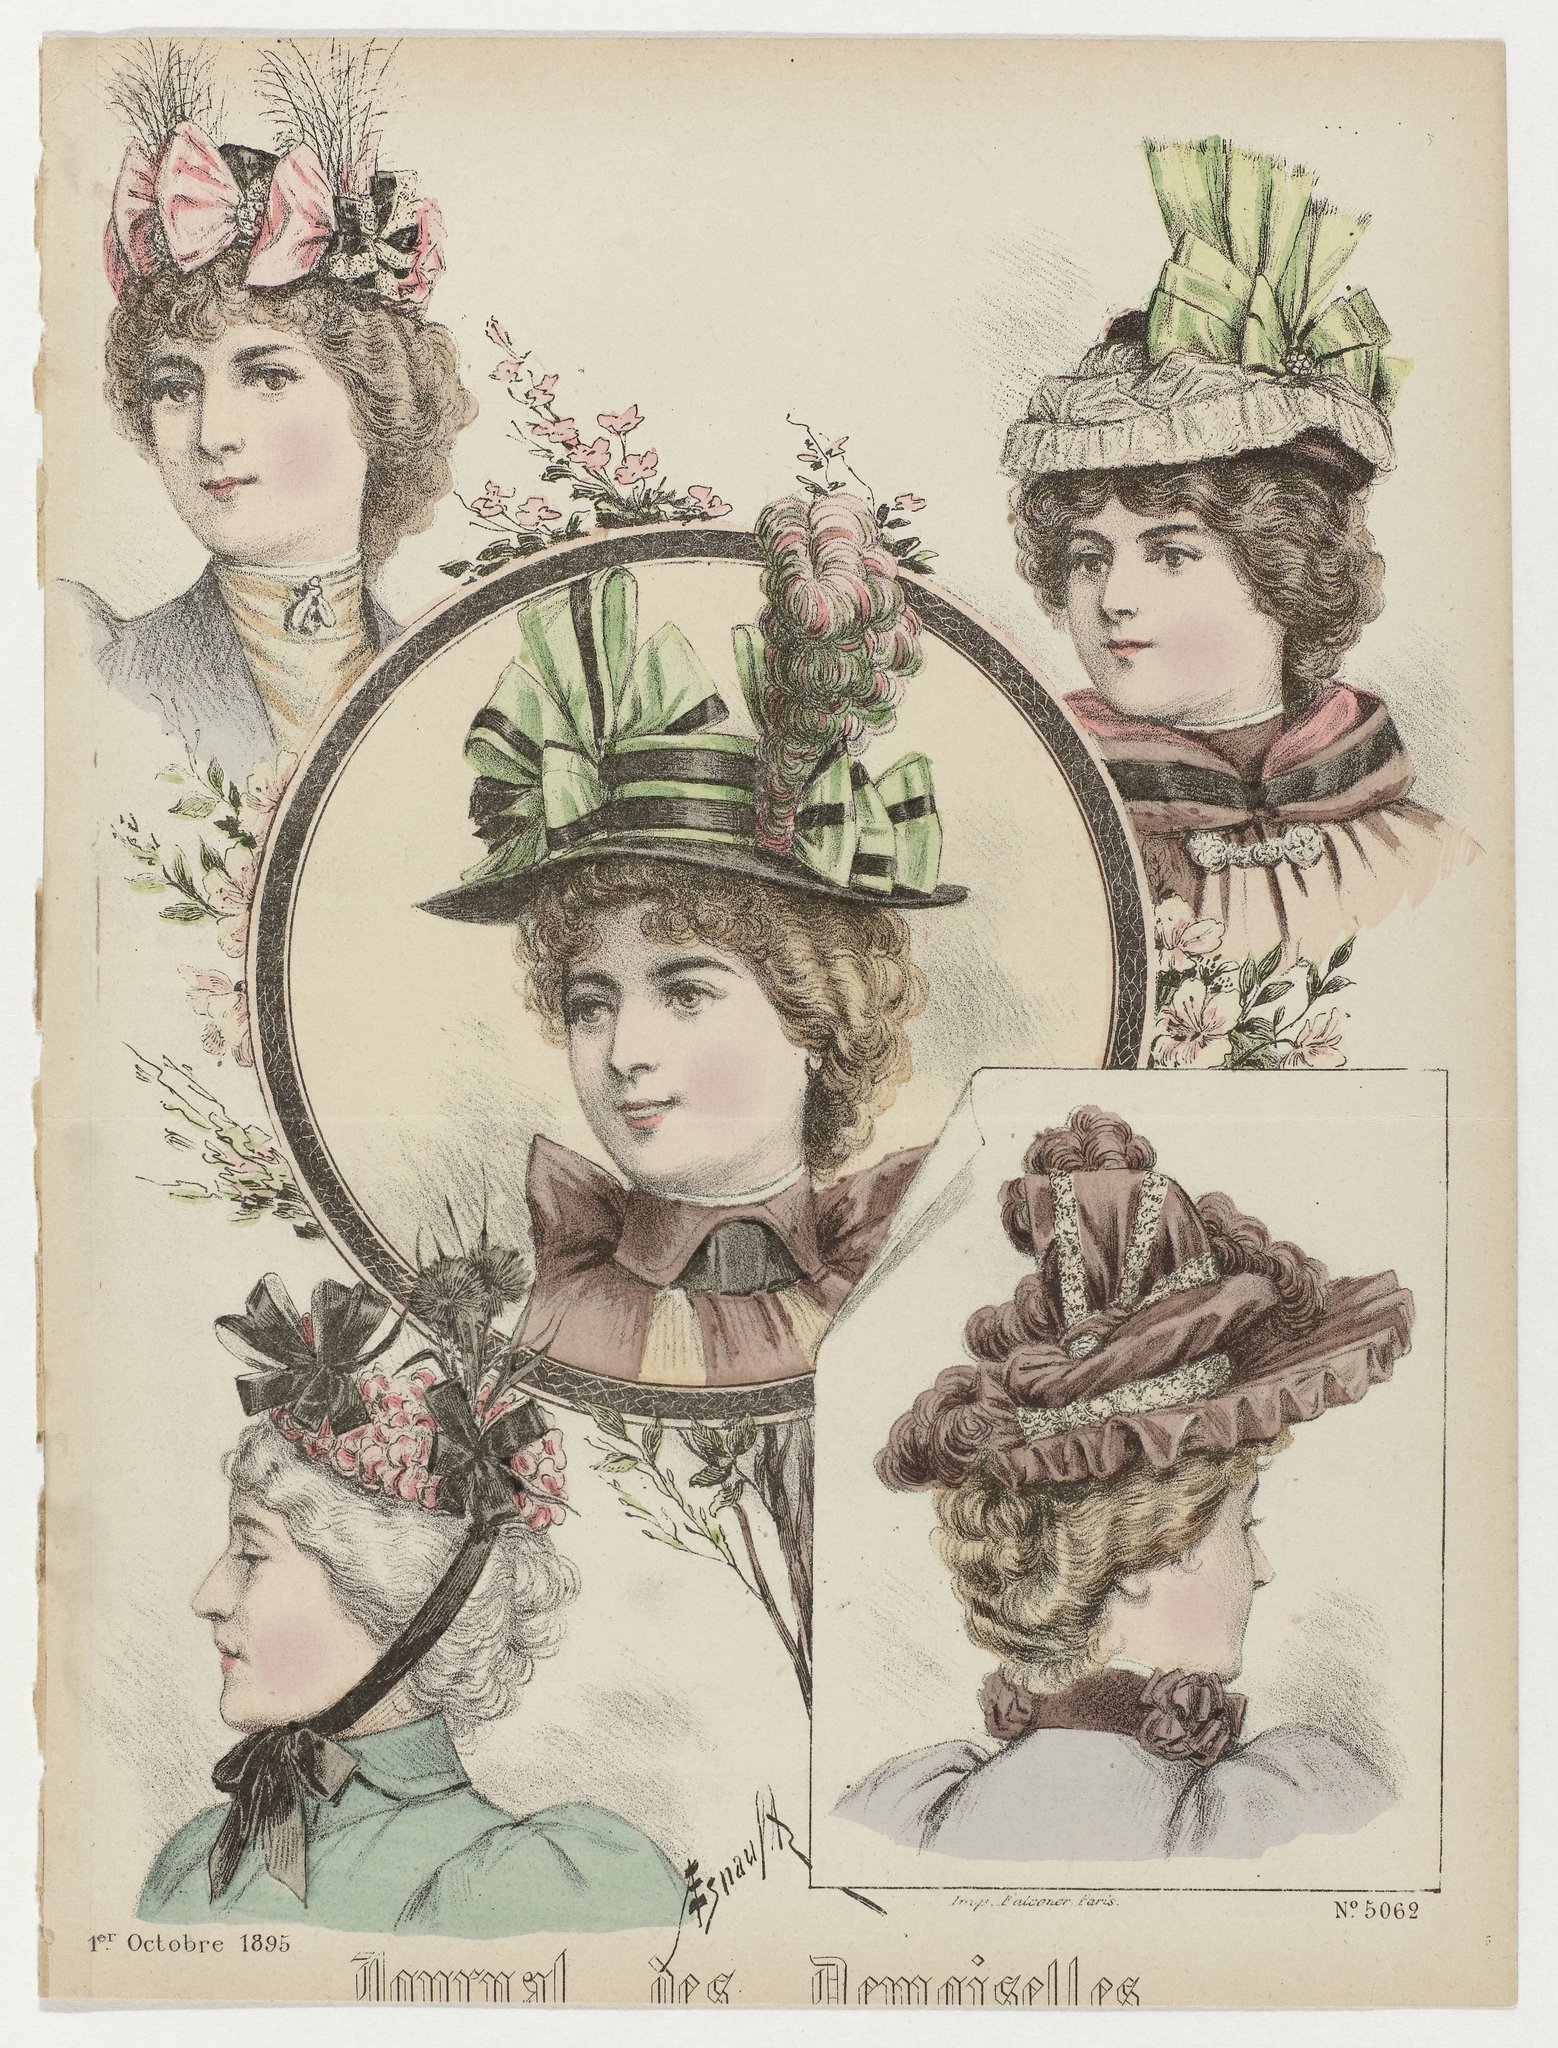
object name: fashion print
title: Journal des Demoiselles, 1 Octobre 1895, No. 5062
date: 1895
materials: paper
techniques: hand coloring, lithograph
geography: paris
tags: border, ribbon, braid (+ women's clothes), fashion plates, head-gear: hat (+ women's clothes), head-gear: hat (+ feathers used for clothes)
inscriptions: title: ‘Journal des Demoiselles’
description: Vijf vrouwenhoofden, waarvan twee in kaders, met verschillende hoeden versierd met linten en veren. Prent uit het modetijdschrift Journal des Demoiselles (1833 -1922).